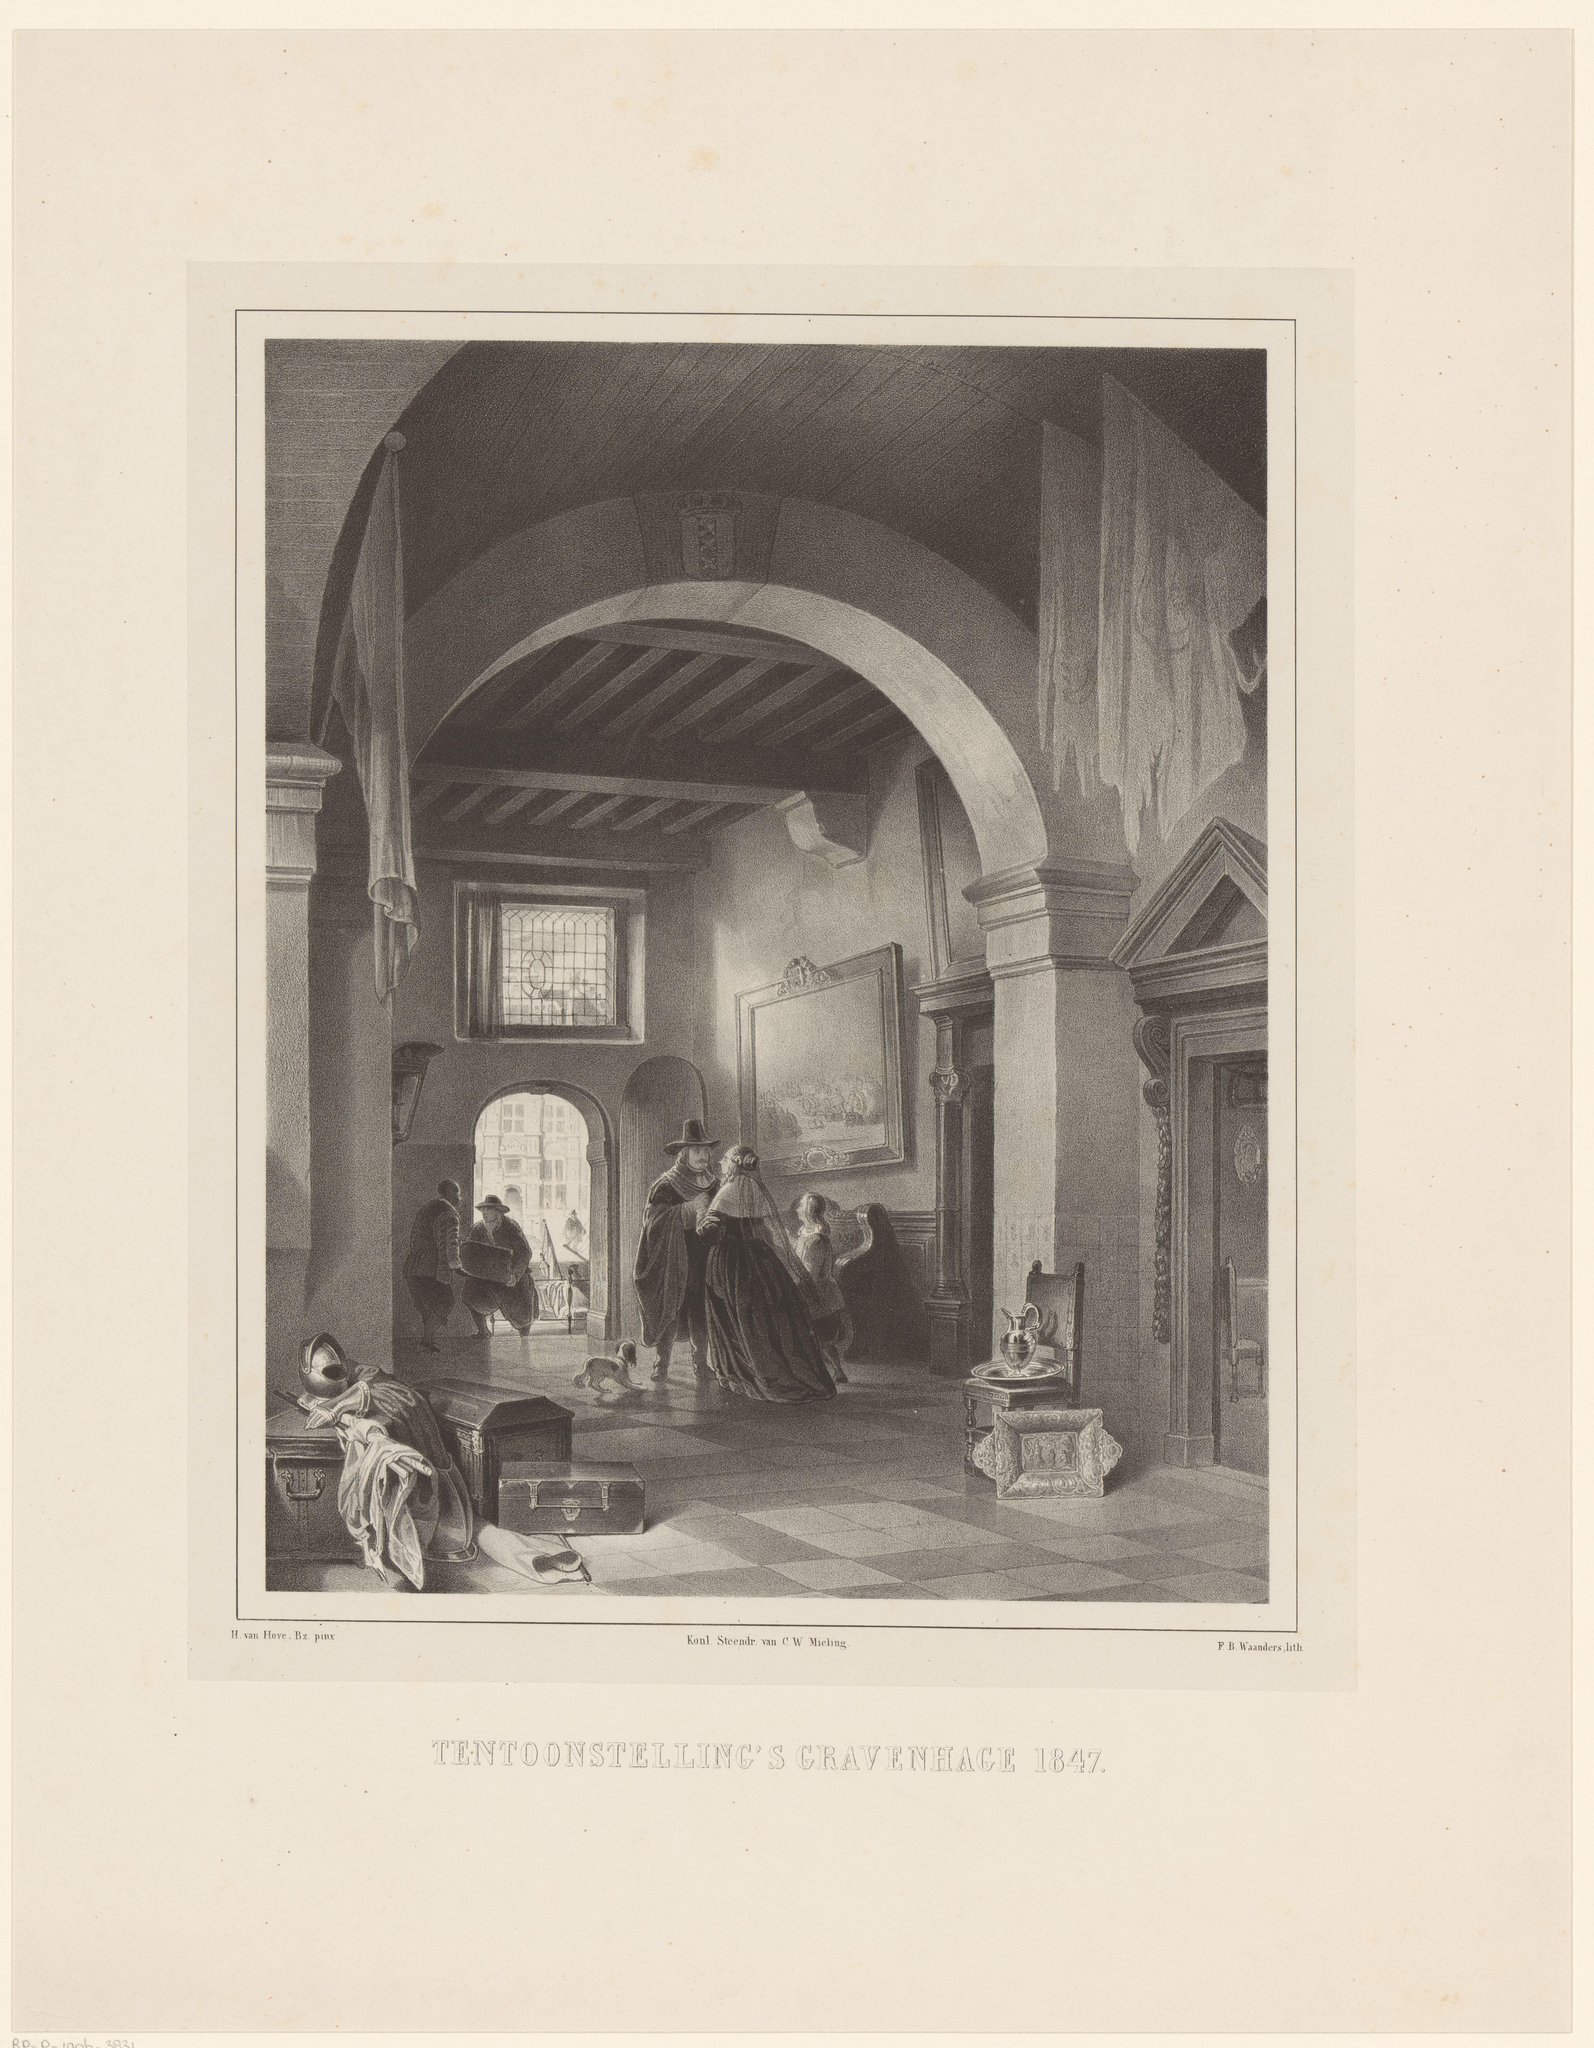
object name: print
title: Tentoonstelling 's Gravenhage 1847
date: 1847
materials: paper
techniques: lithograph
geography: the hague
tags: being welcomed ~ travelling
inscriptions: collector's mark: Lugt 2228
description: In een zeventiende-eeuws interieur wordt een man bij thuiskomst begroet door zijn vrouw, kind en hond. Twee mannen dragen een kist binnen. Links op de voorgrond staan drie kisten.